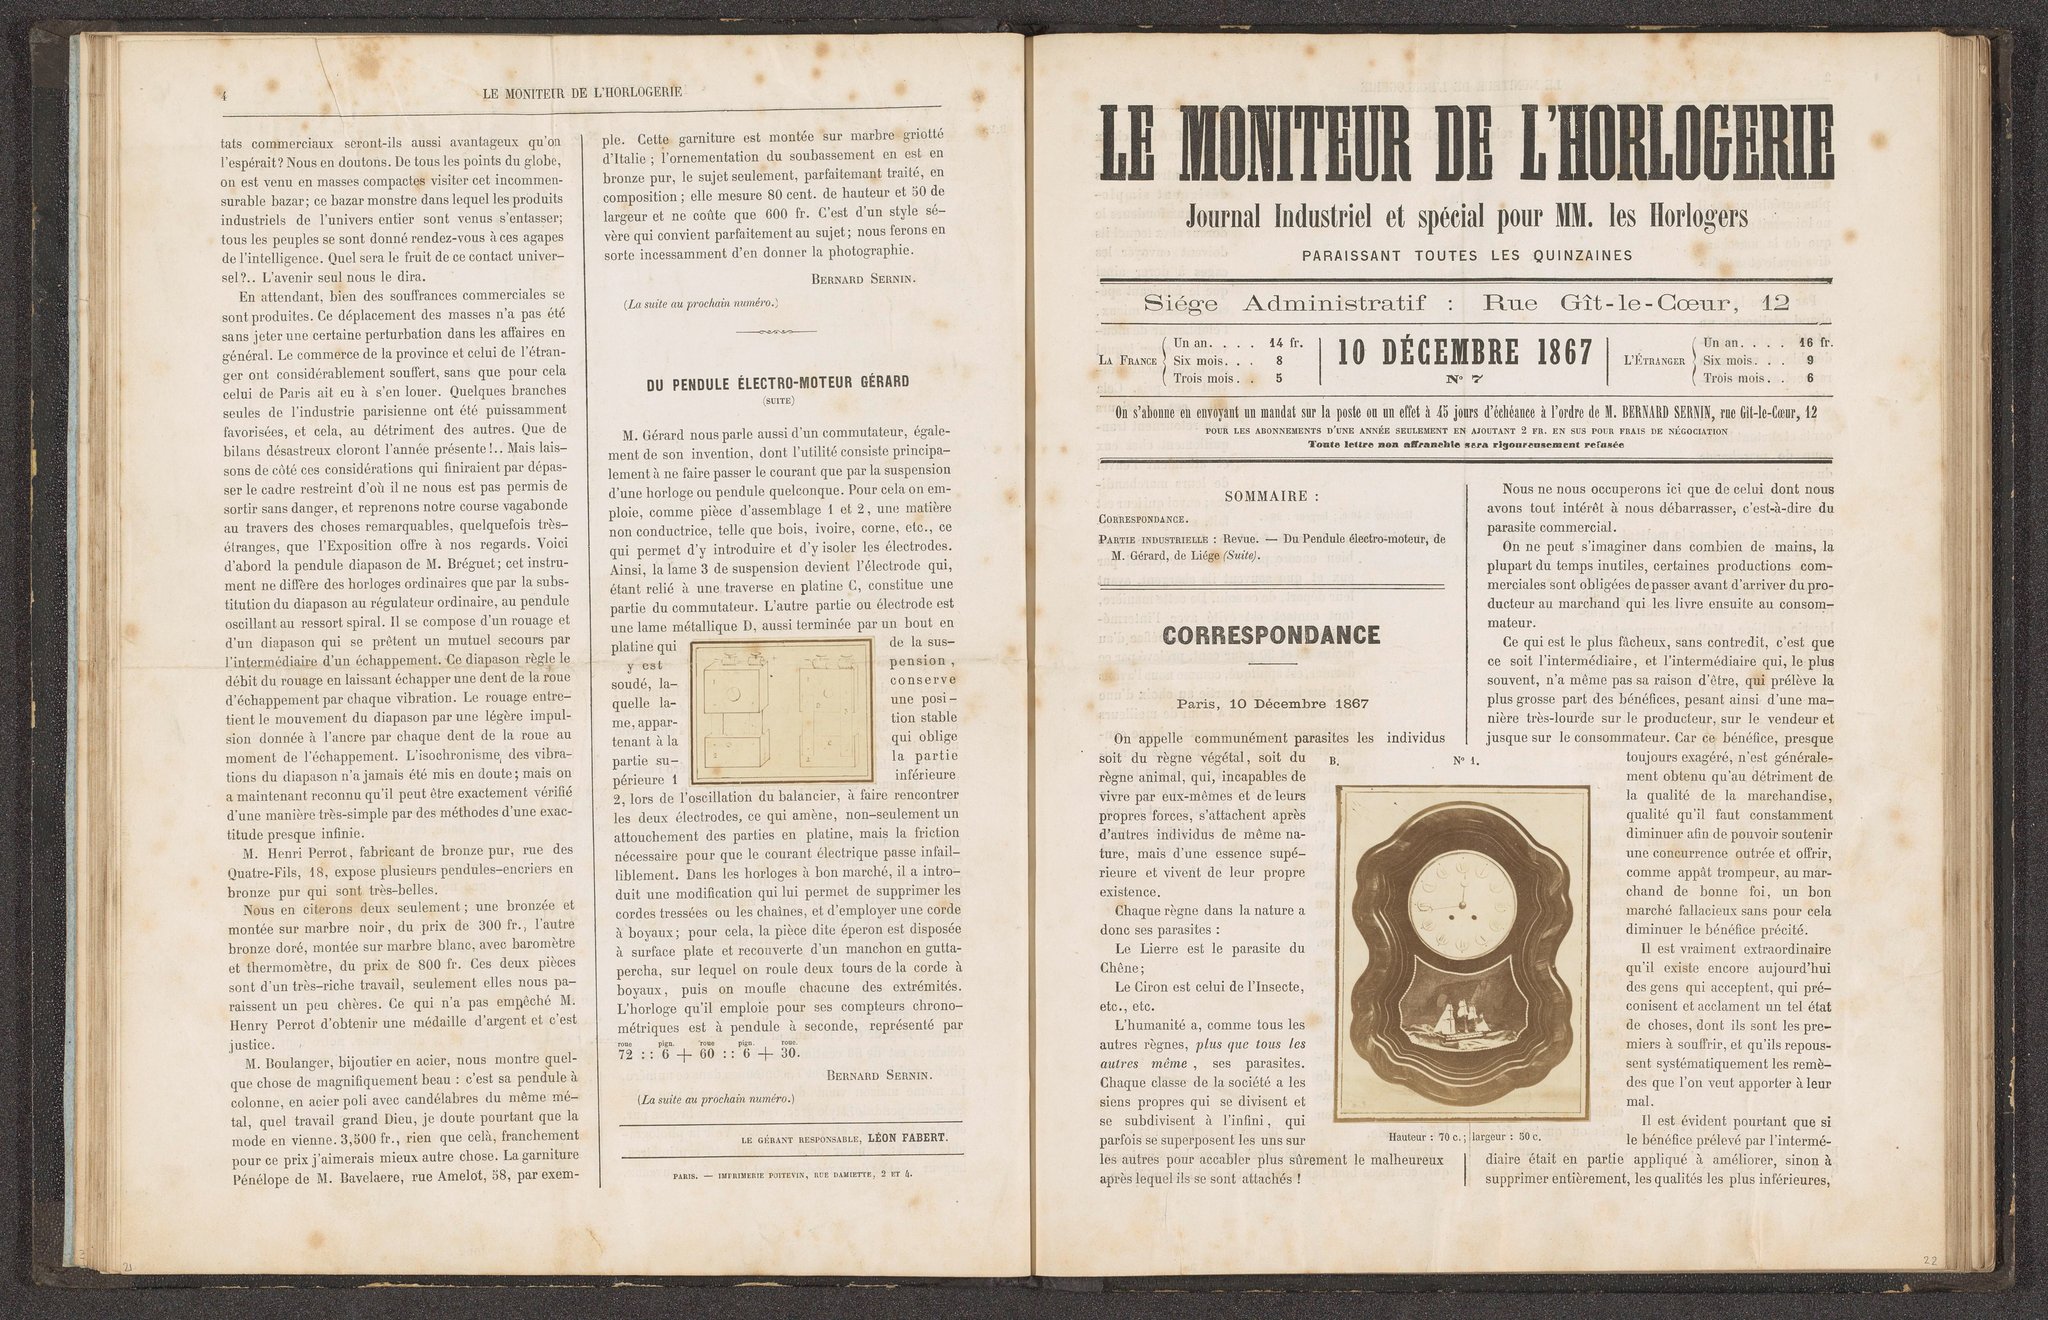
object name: page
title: Klok gedecoreerd met een schip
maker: Anonymous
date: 1857-1867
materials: photographic support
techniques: albumen print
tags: clock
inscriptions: number: ‘No 1.’